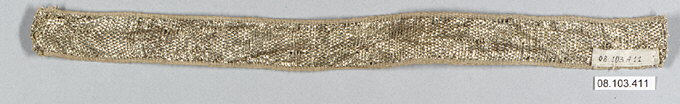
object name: galloon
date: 1701-1800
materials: metal thread